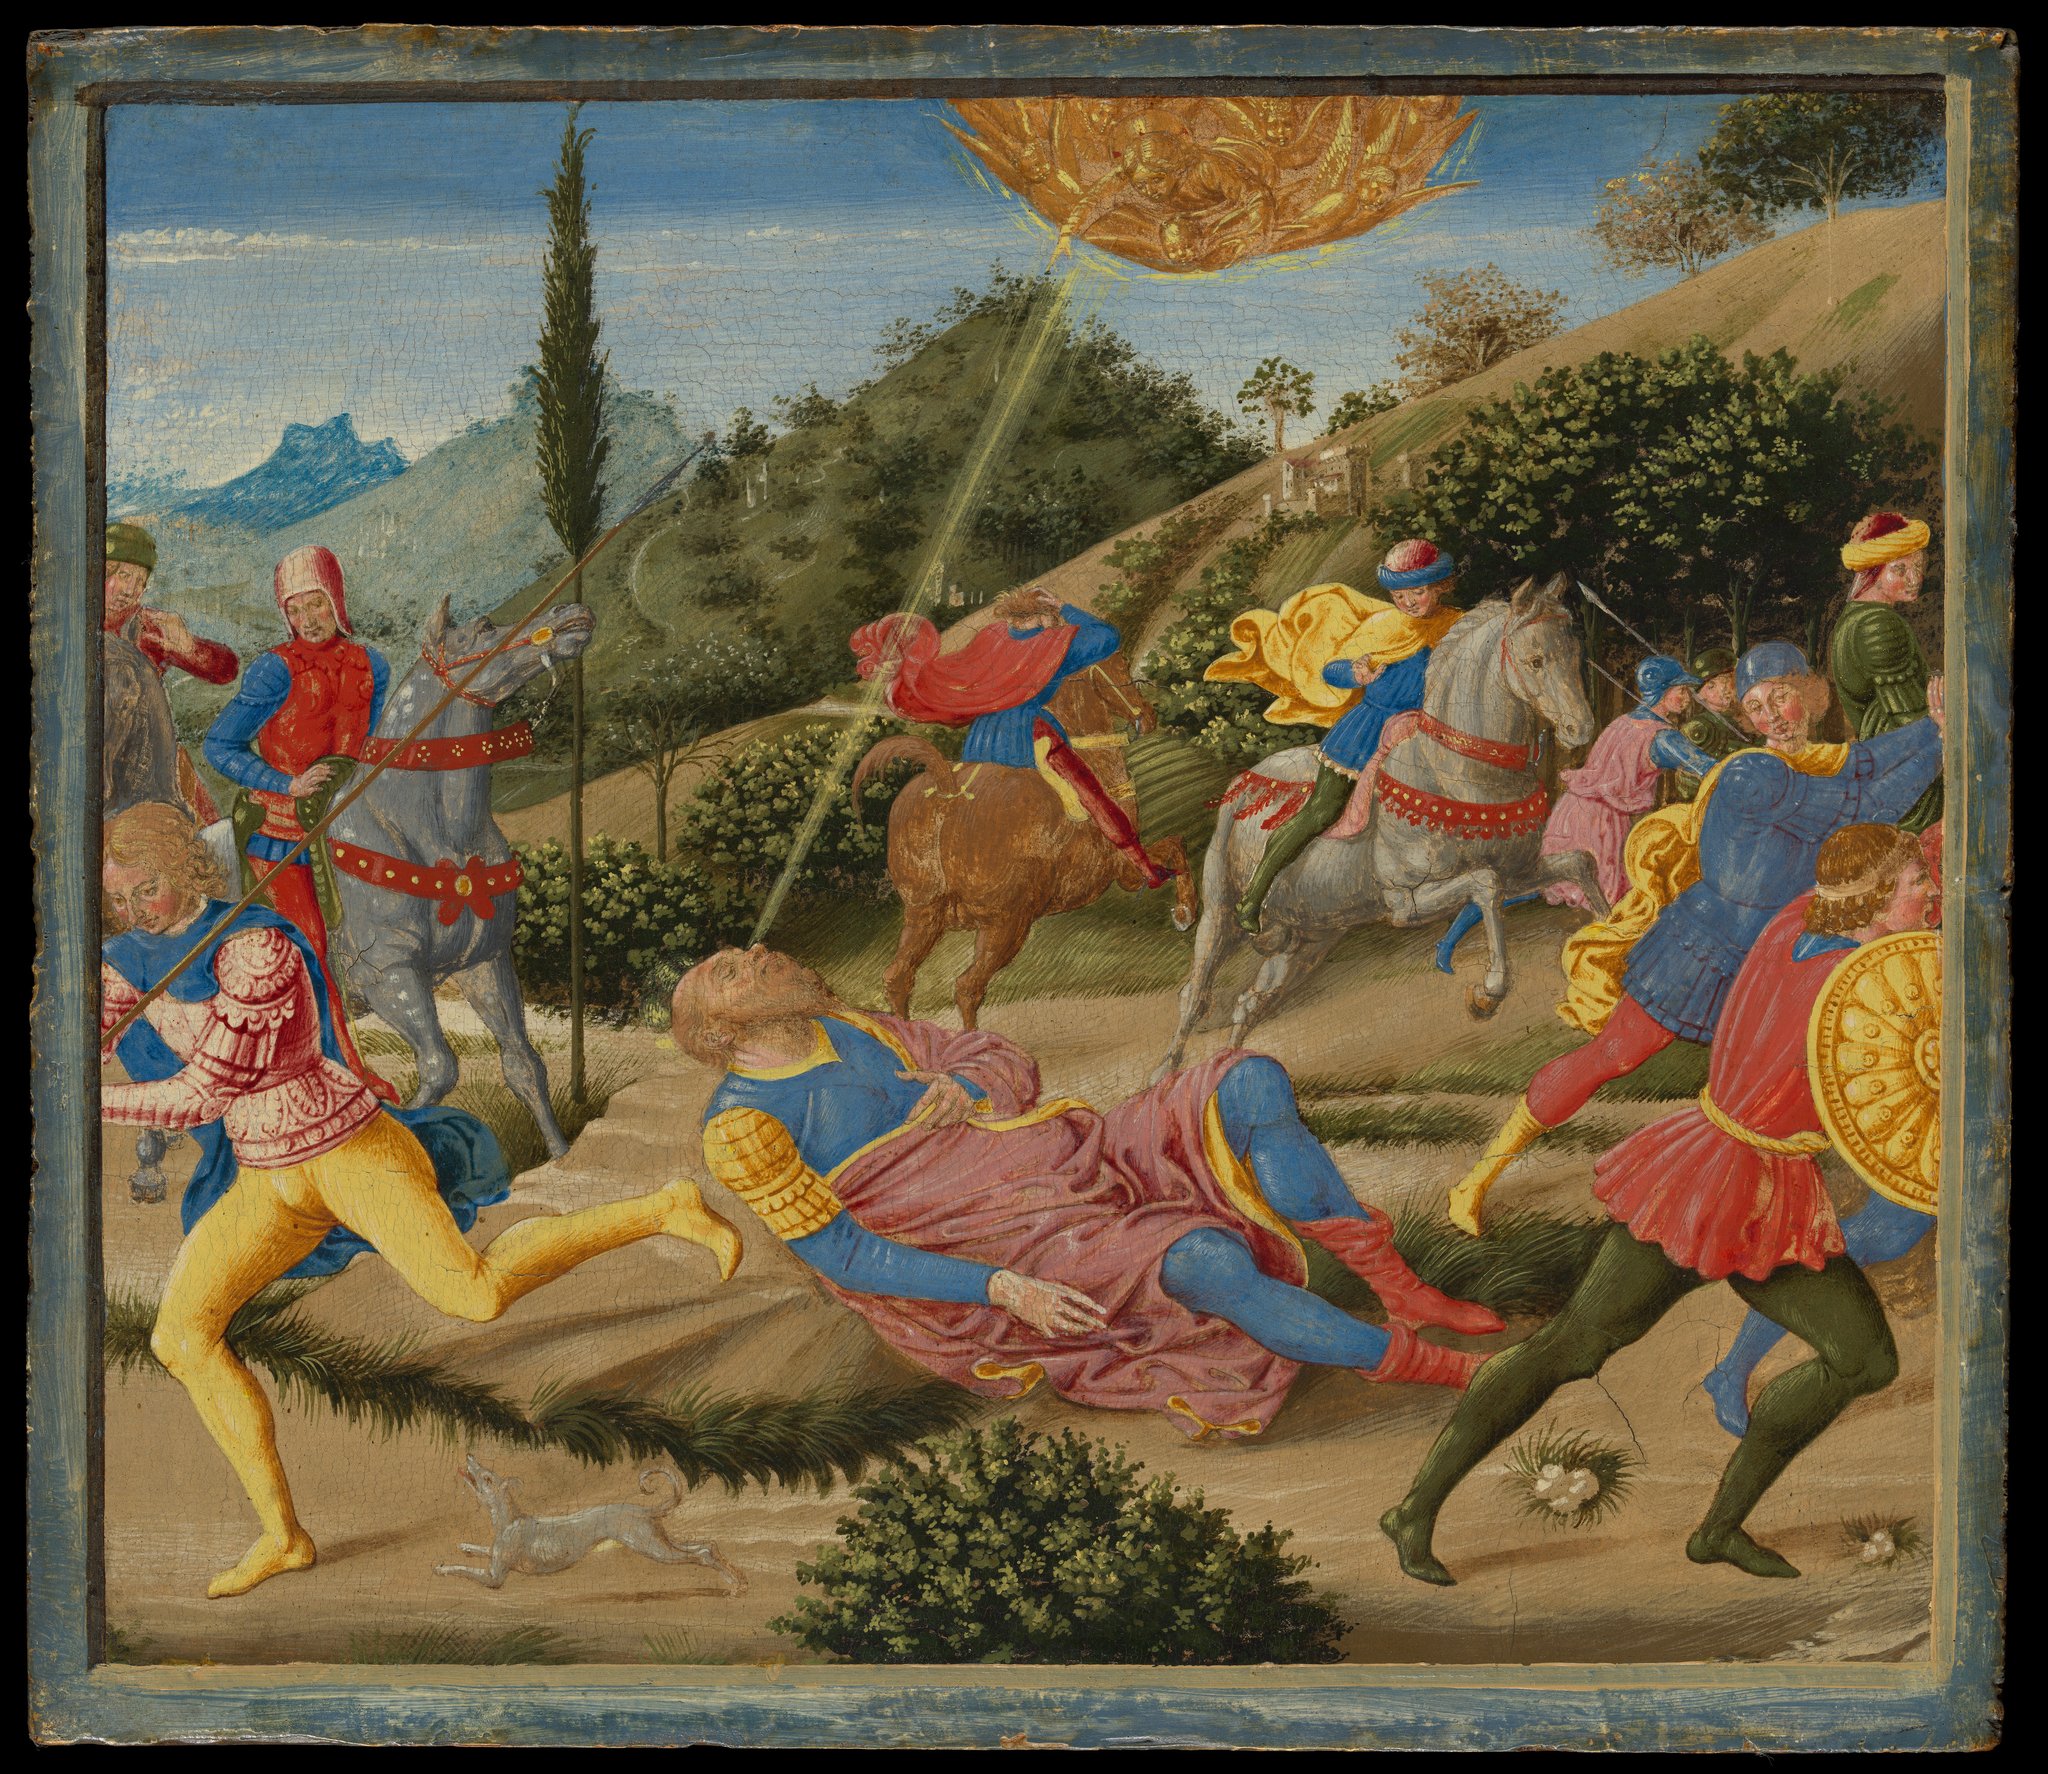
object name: painting, predella panel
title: The Conversion of Saint Paul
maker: benozzo gozzoli (benozzo di lese di sandro)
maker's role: artist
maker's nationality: italian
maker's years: 1420-1497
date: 1440-1497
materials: paint, wood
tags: soldiers,men,dogs,horses,angels,saint paul